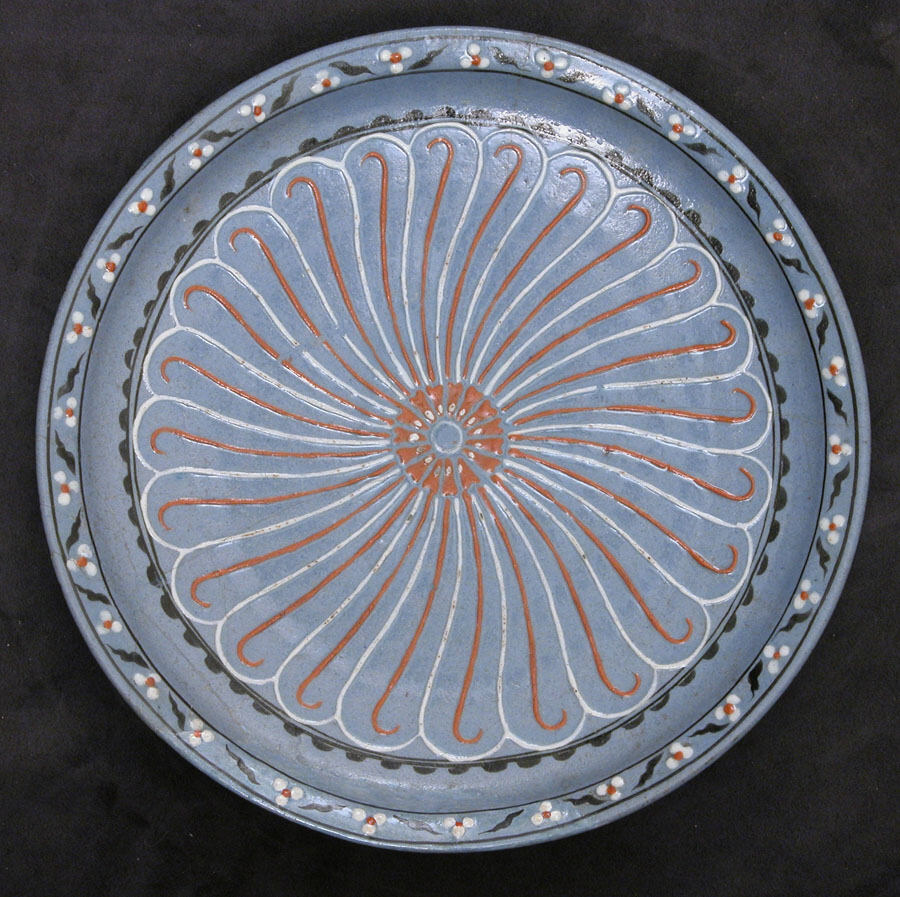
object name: dish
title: Blue-ground Dish with Floral and 'Cintamani' Designs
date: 1570-1575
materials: stonepaste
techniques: painting, polychrome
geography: turkey